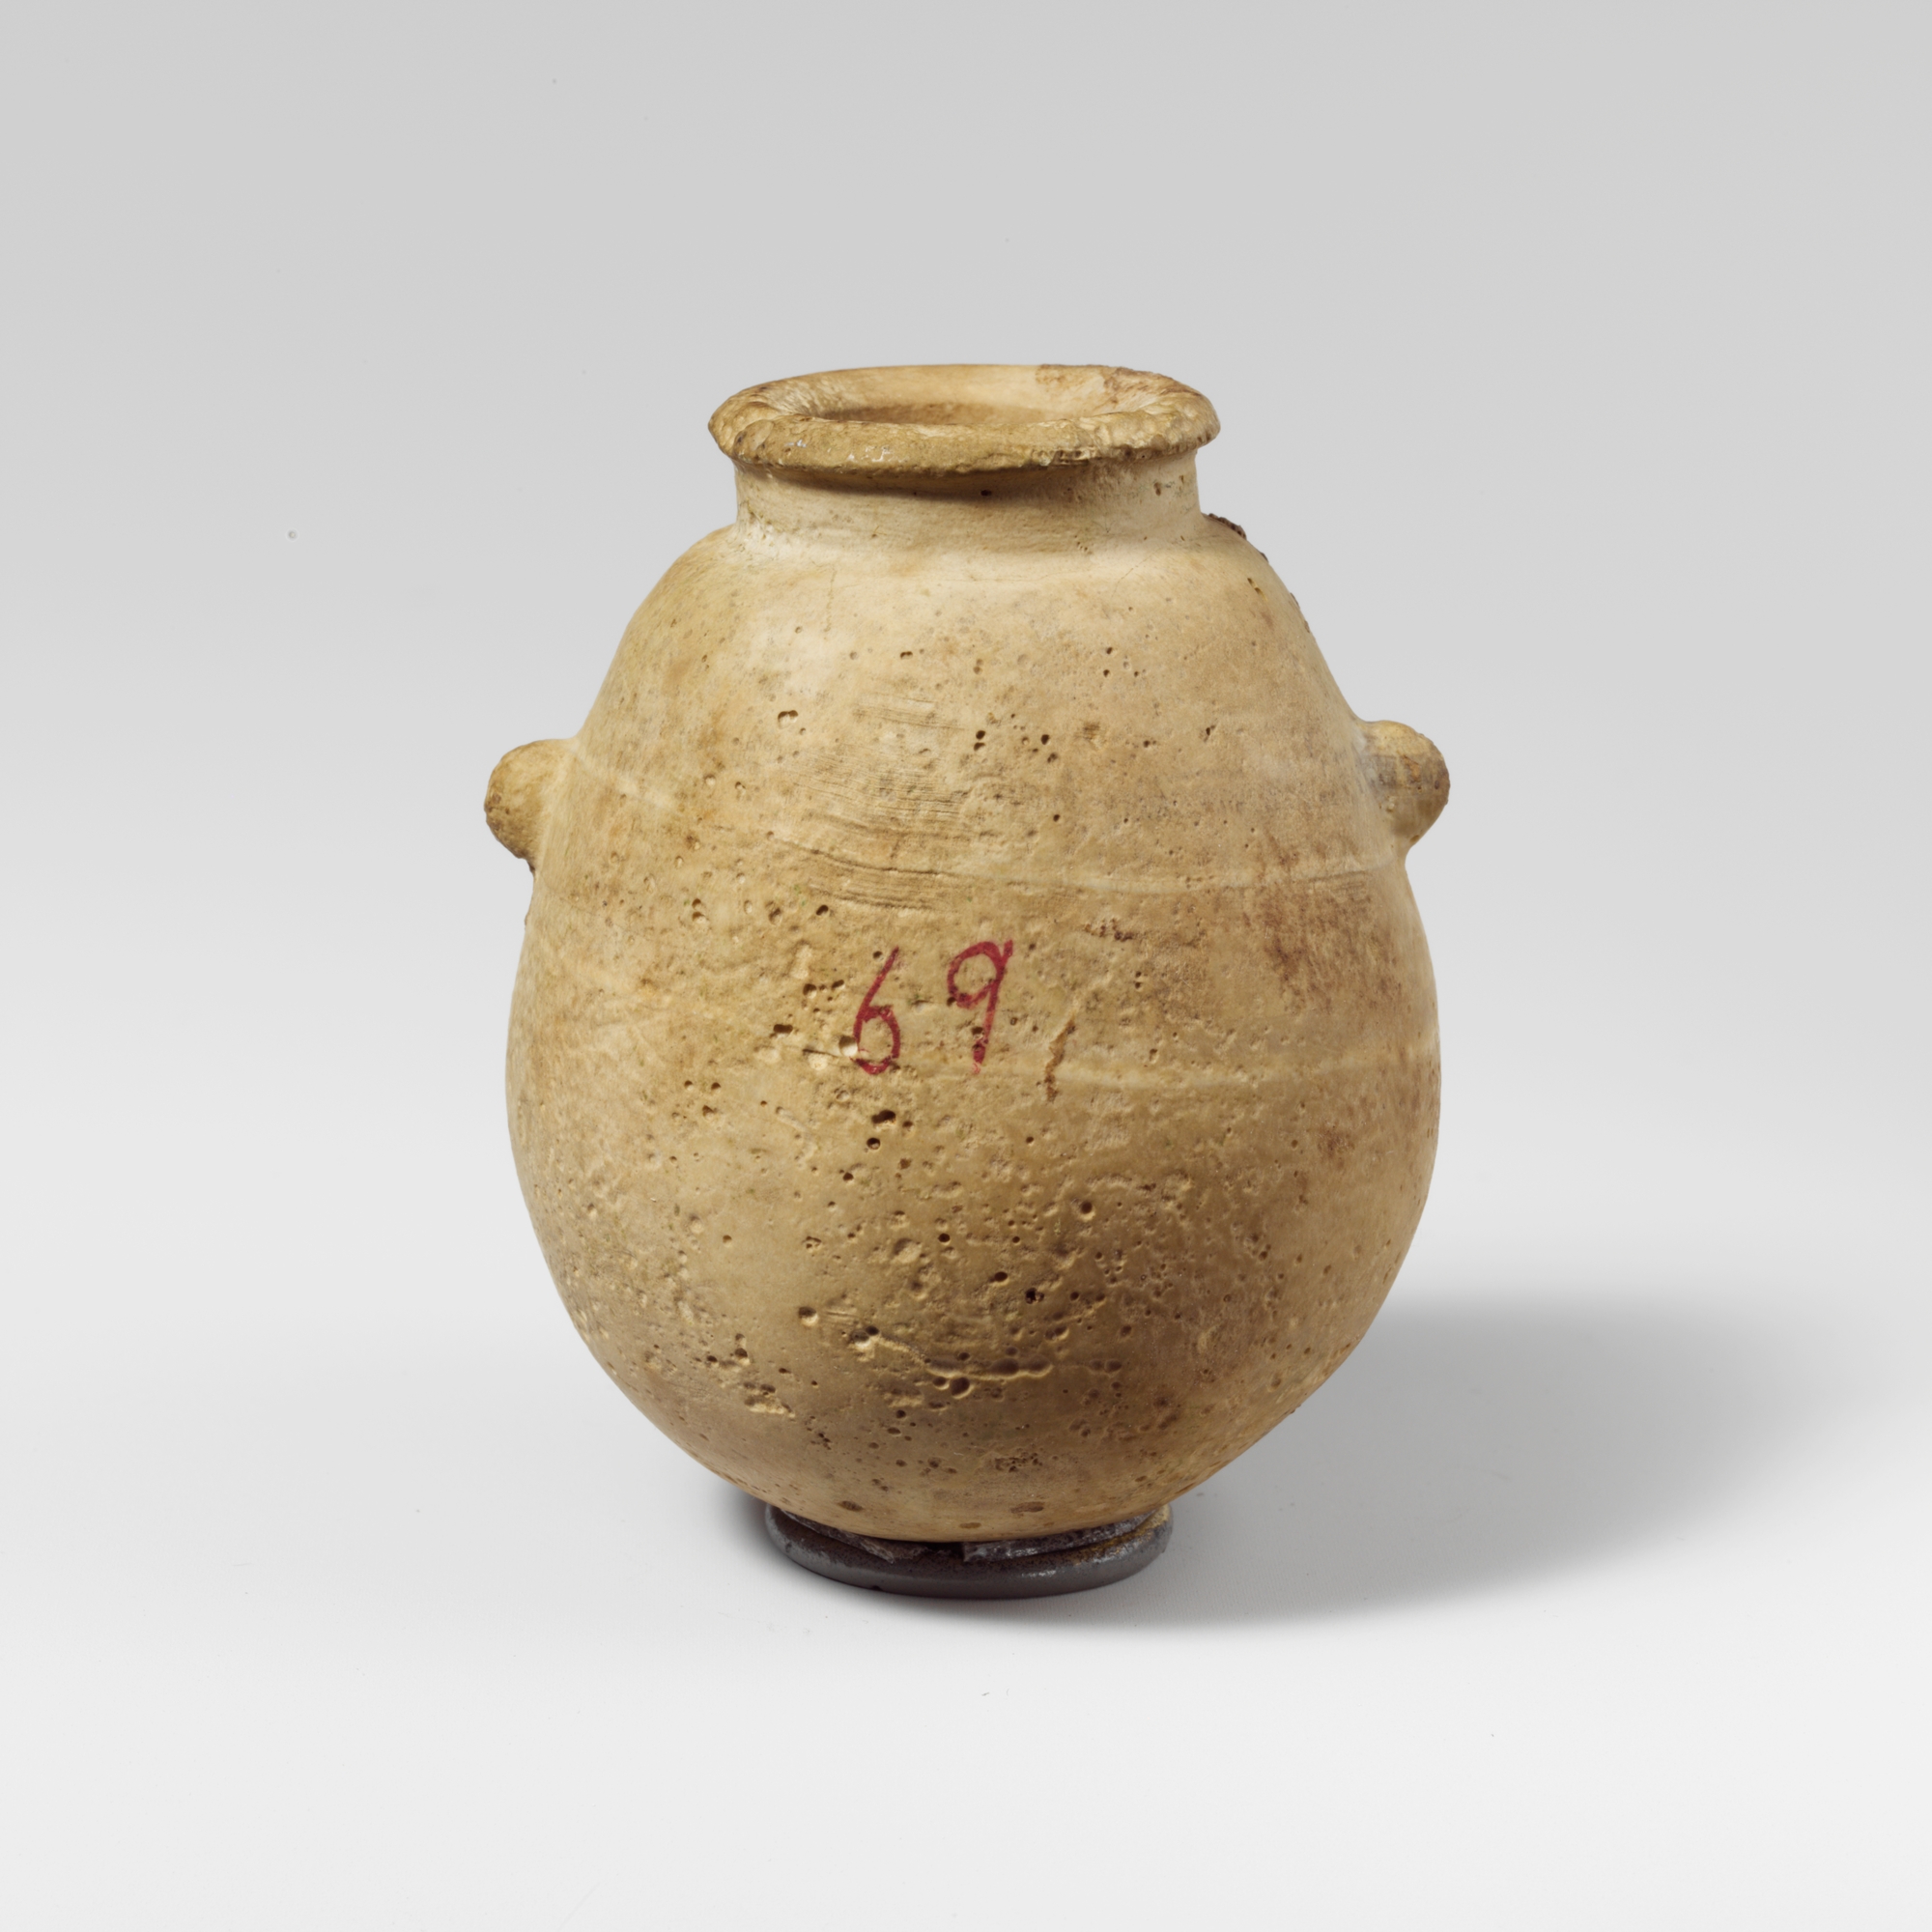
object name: vase, oval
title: Alabaster alabastron (perfume vase)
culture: cypriot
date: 600-401 BCE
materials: alabaster